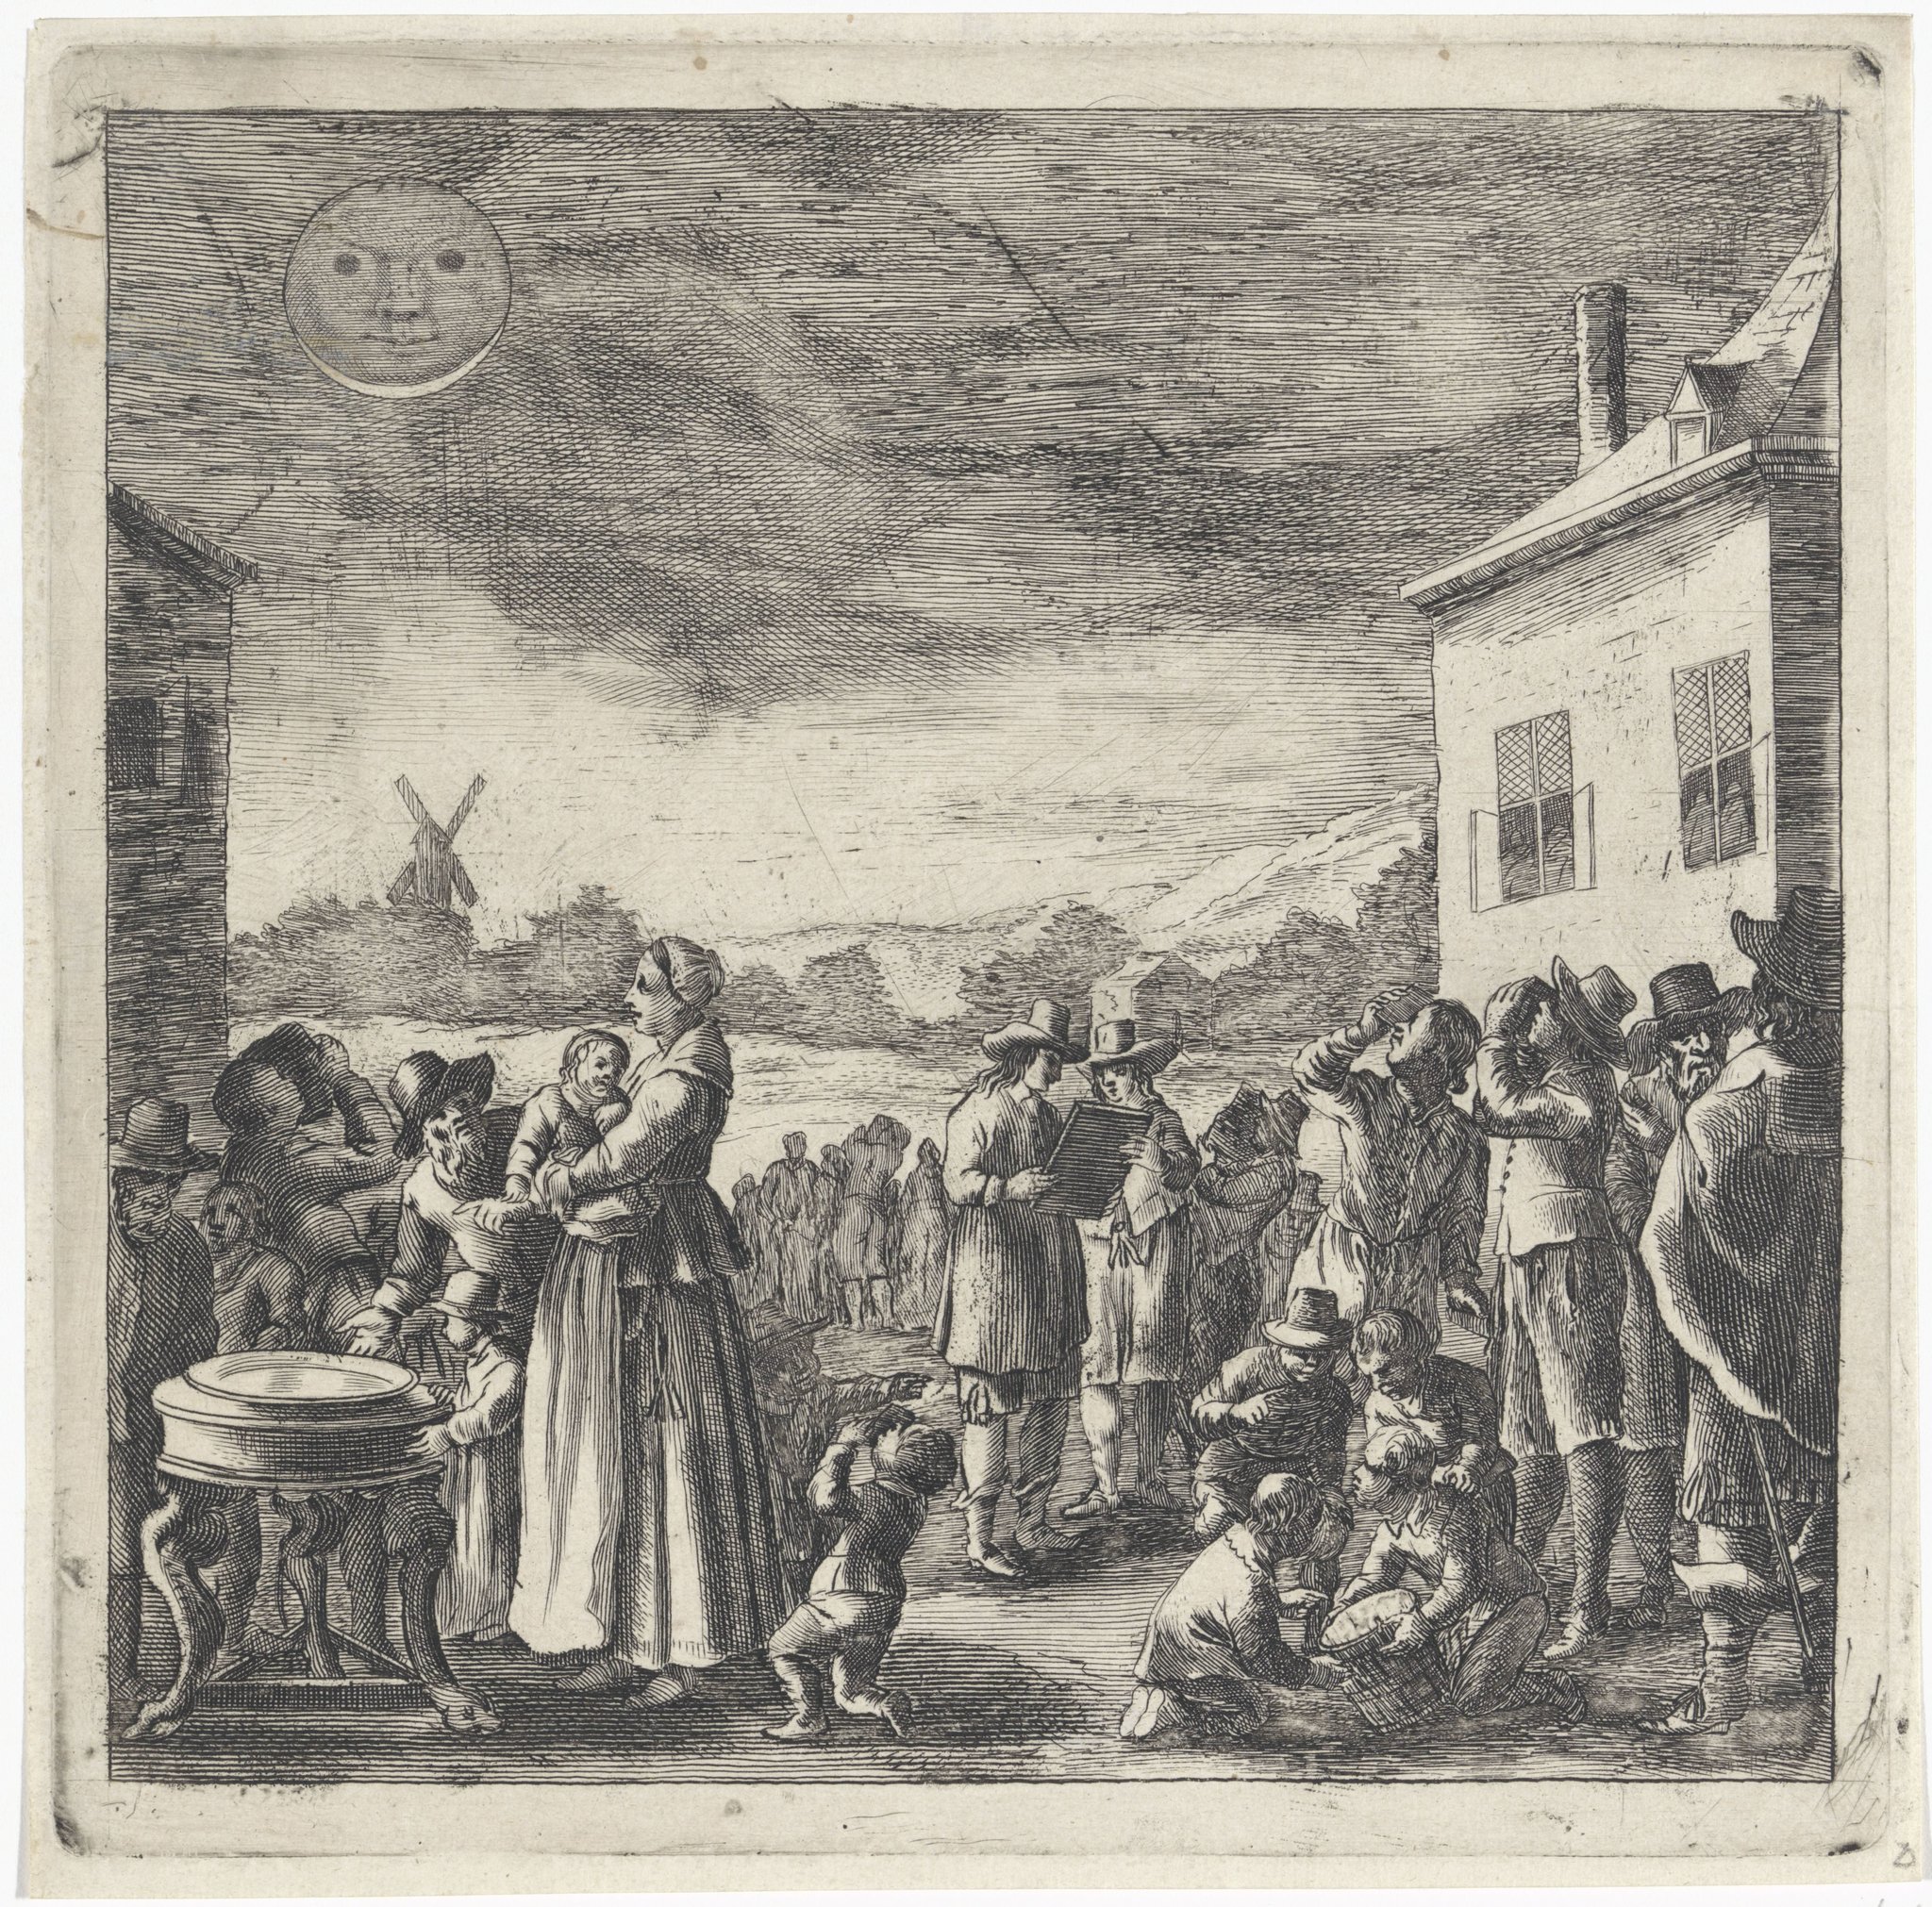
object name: print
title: Zonsverduistering van 12 augustus 1654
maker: Anonymous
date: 1654-1656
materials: paper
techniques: etching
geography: netherlands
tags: solar eclipse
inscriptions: collector's mark: Lugt 2228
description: De zonsverduistering van 12 augustus 1654, waargenomen op verschillende manieren door een groep mensen buitenshuis. Links wijst een man op een een bekken met water. Twee mannen bekijken de eclips met een spiegel. Anderen kijken door een stuk glas naar de zon. De verduisterde zon heeft een mensengezicht.